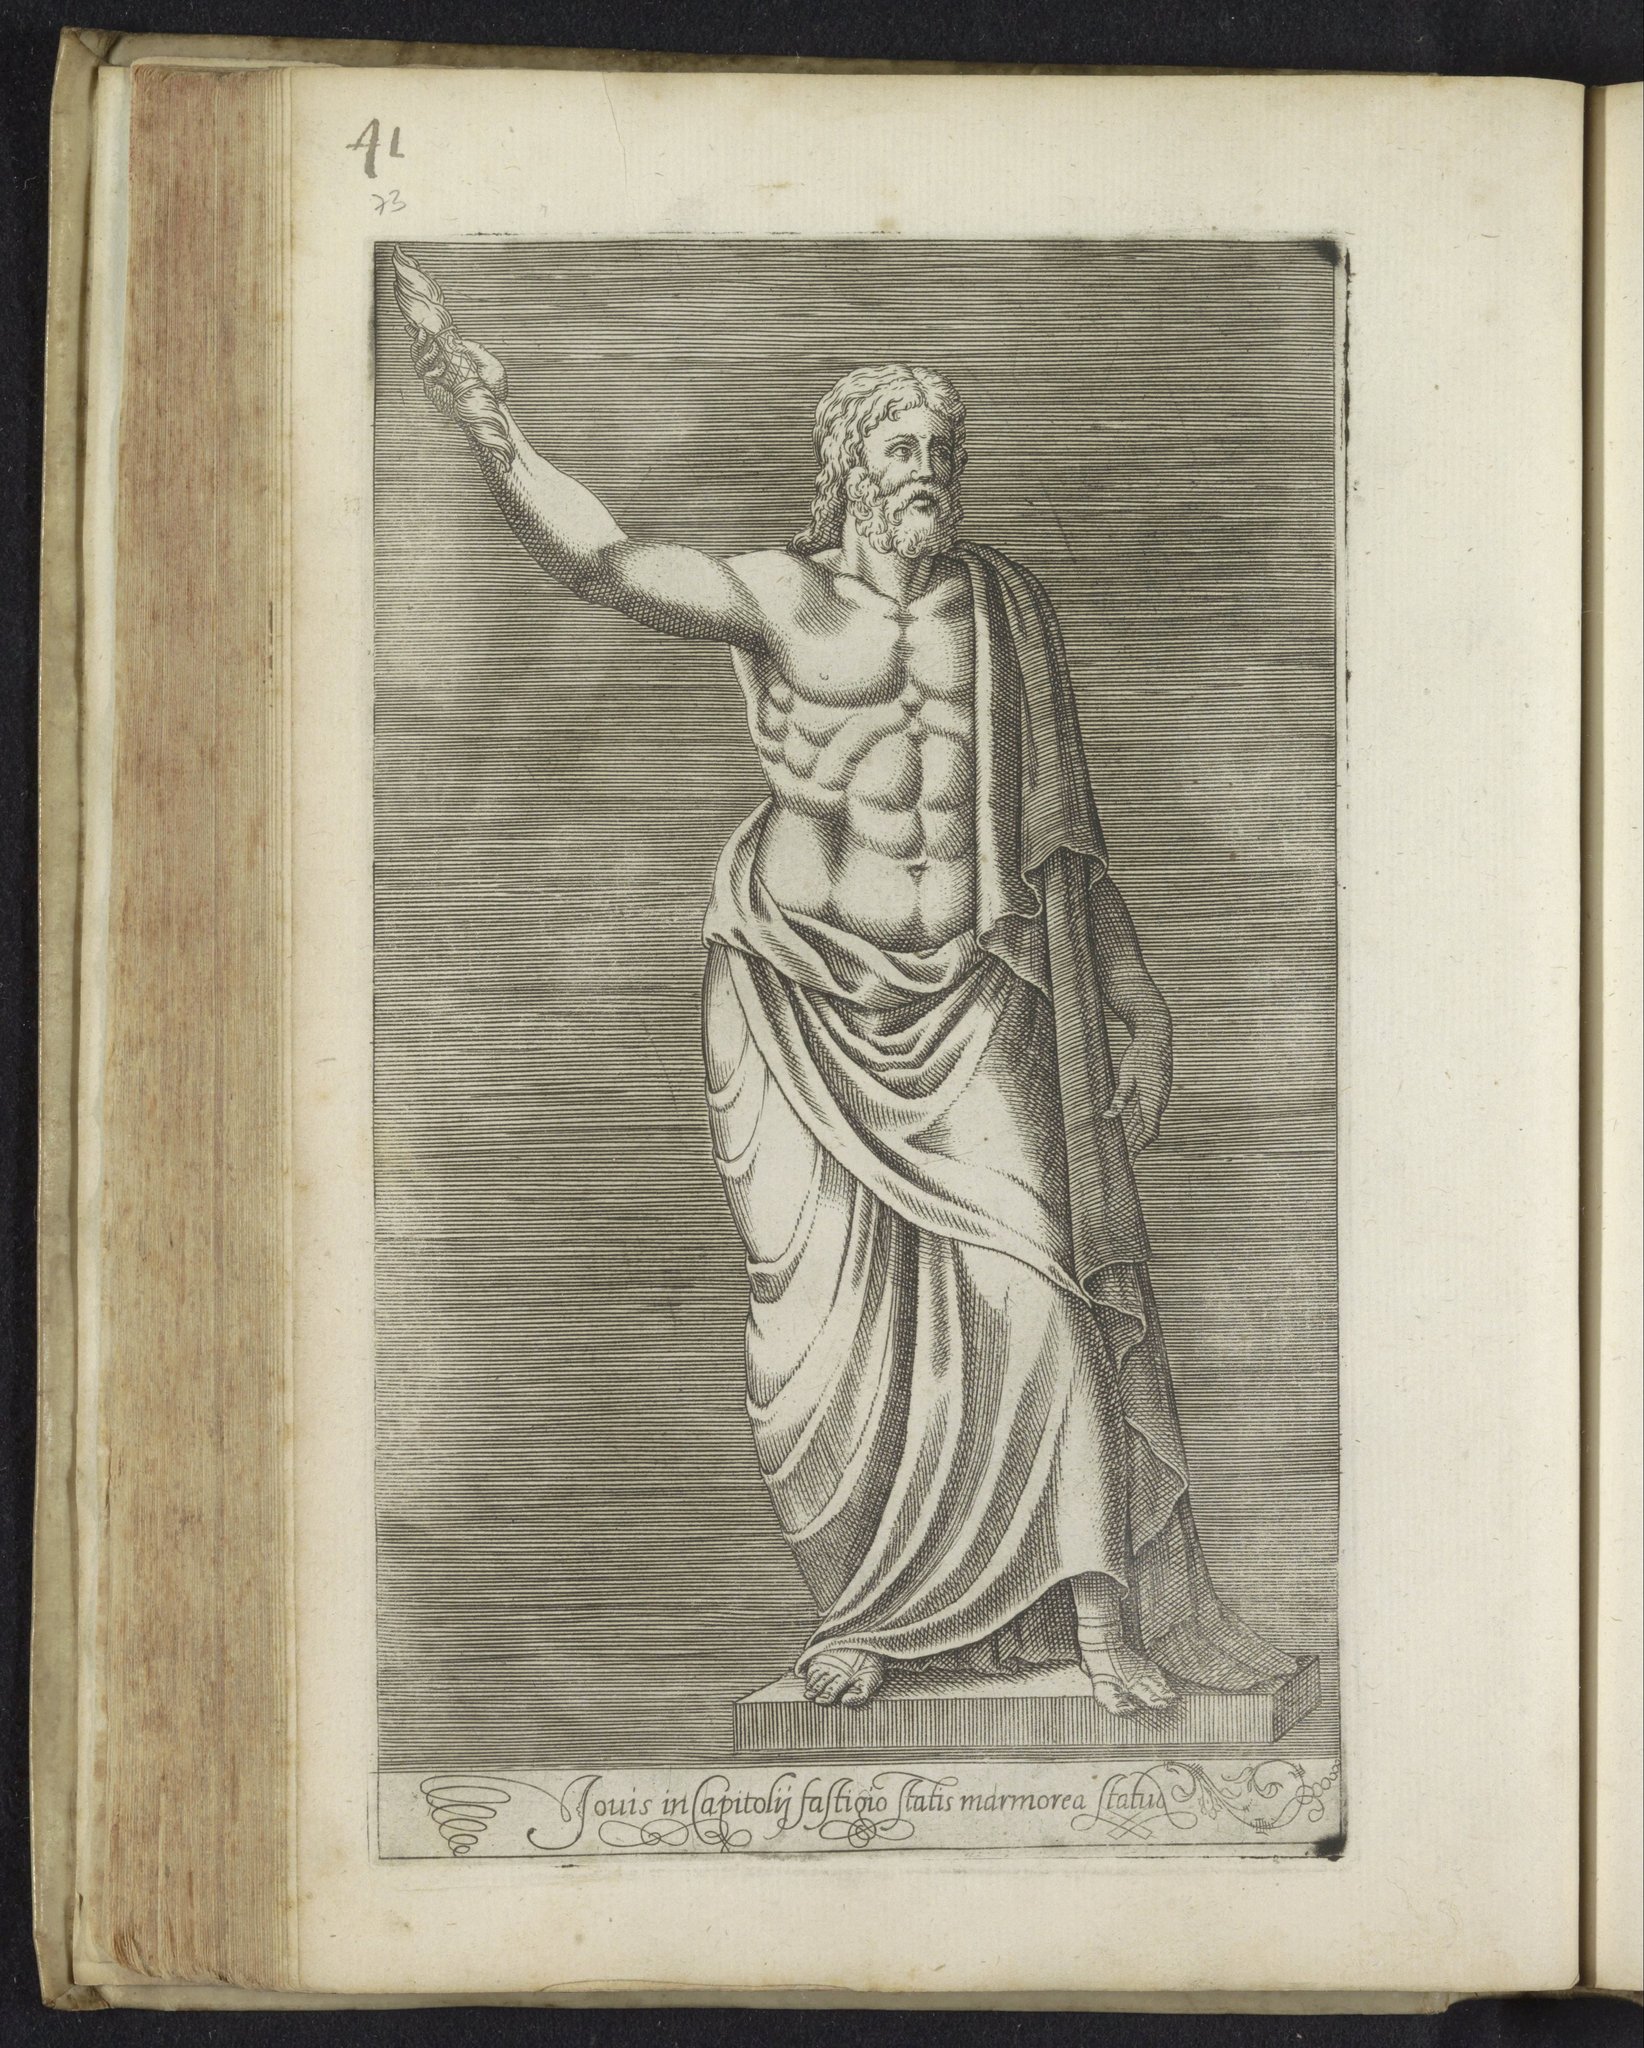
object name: print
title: Antiquarum statuarum urbis Romae quae in publicis locis visuntur icones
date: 1584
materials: paper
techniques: engraving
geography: italy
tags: (story of) jupiter (zeus), piece of sculpture, reproduction of a piece of sculpture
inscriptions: number: ‘41’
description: Deze prent maakt deel uit van een set van 79 prenten (+ titelprent) met voorstellingen van antieke sculpturen in Rome.